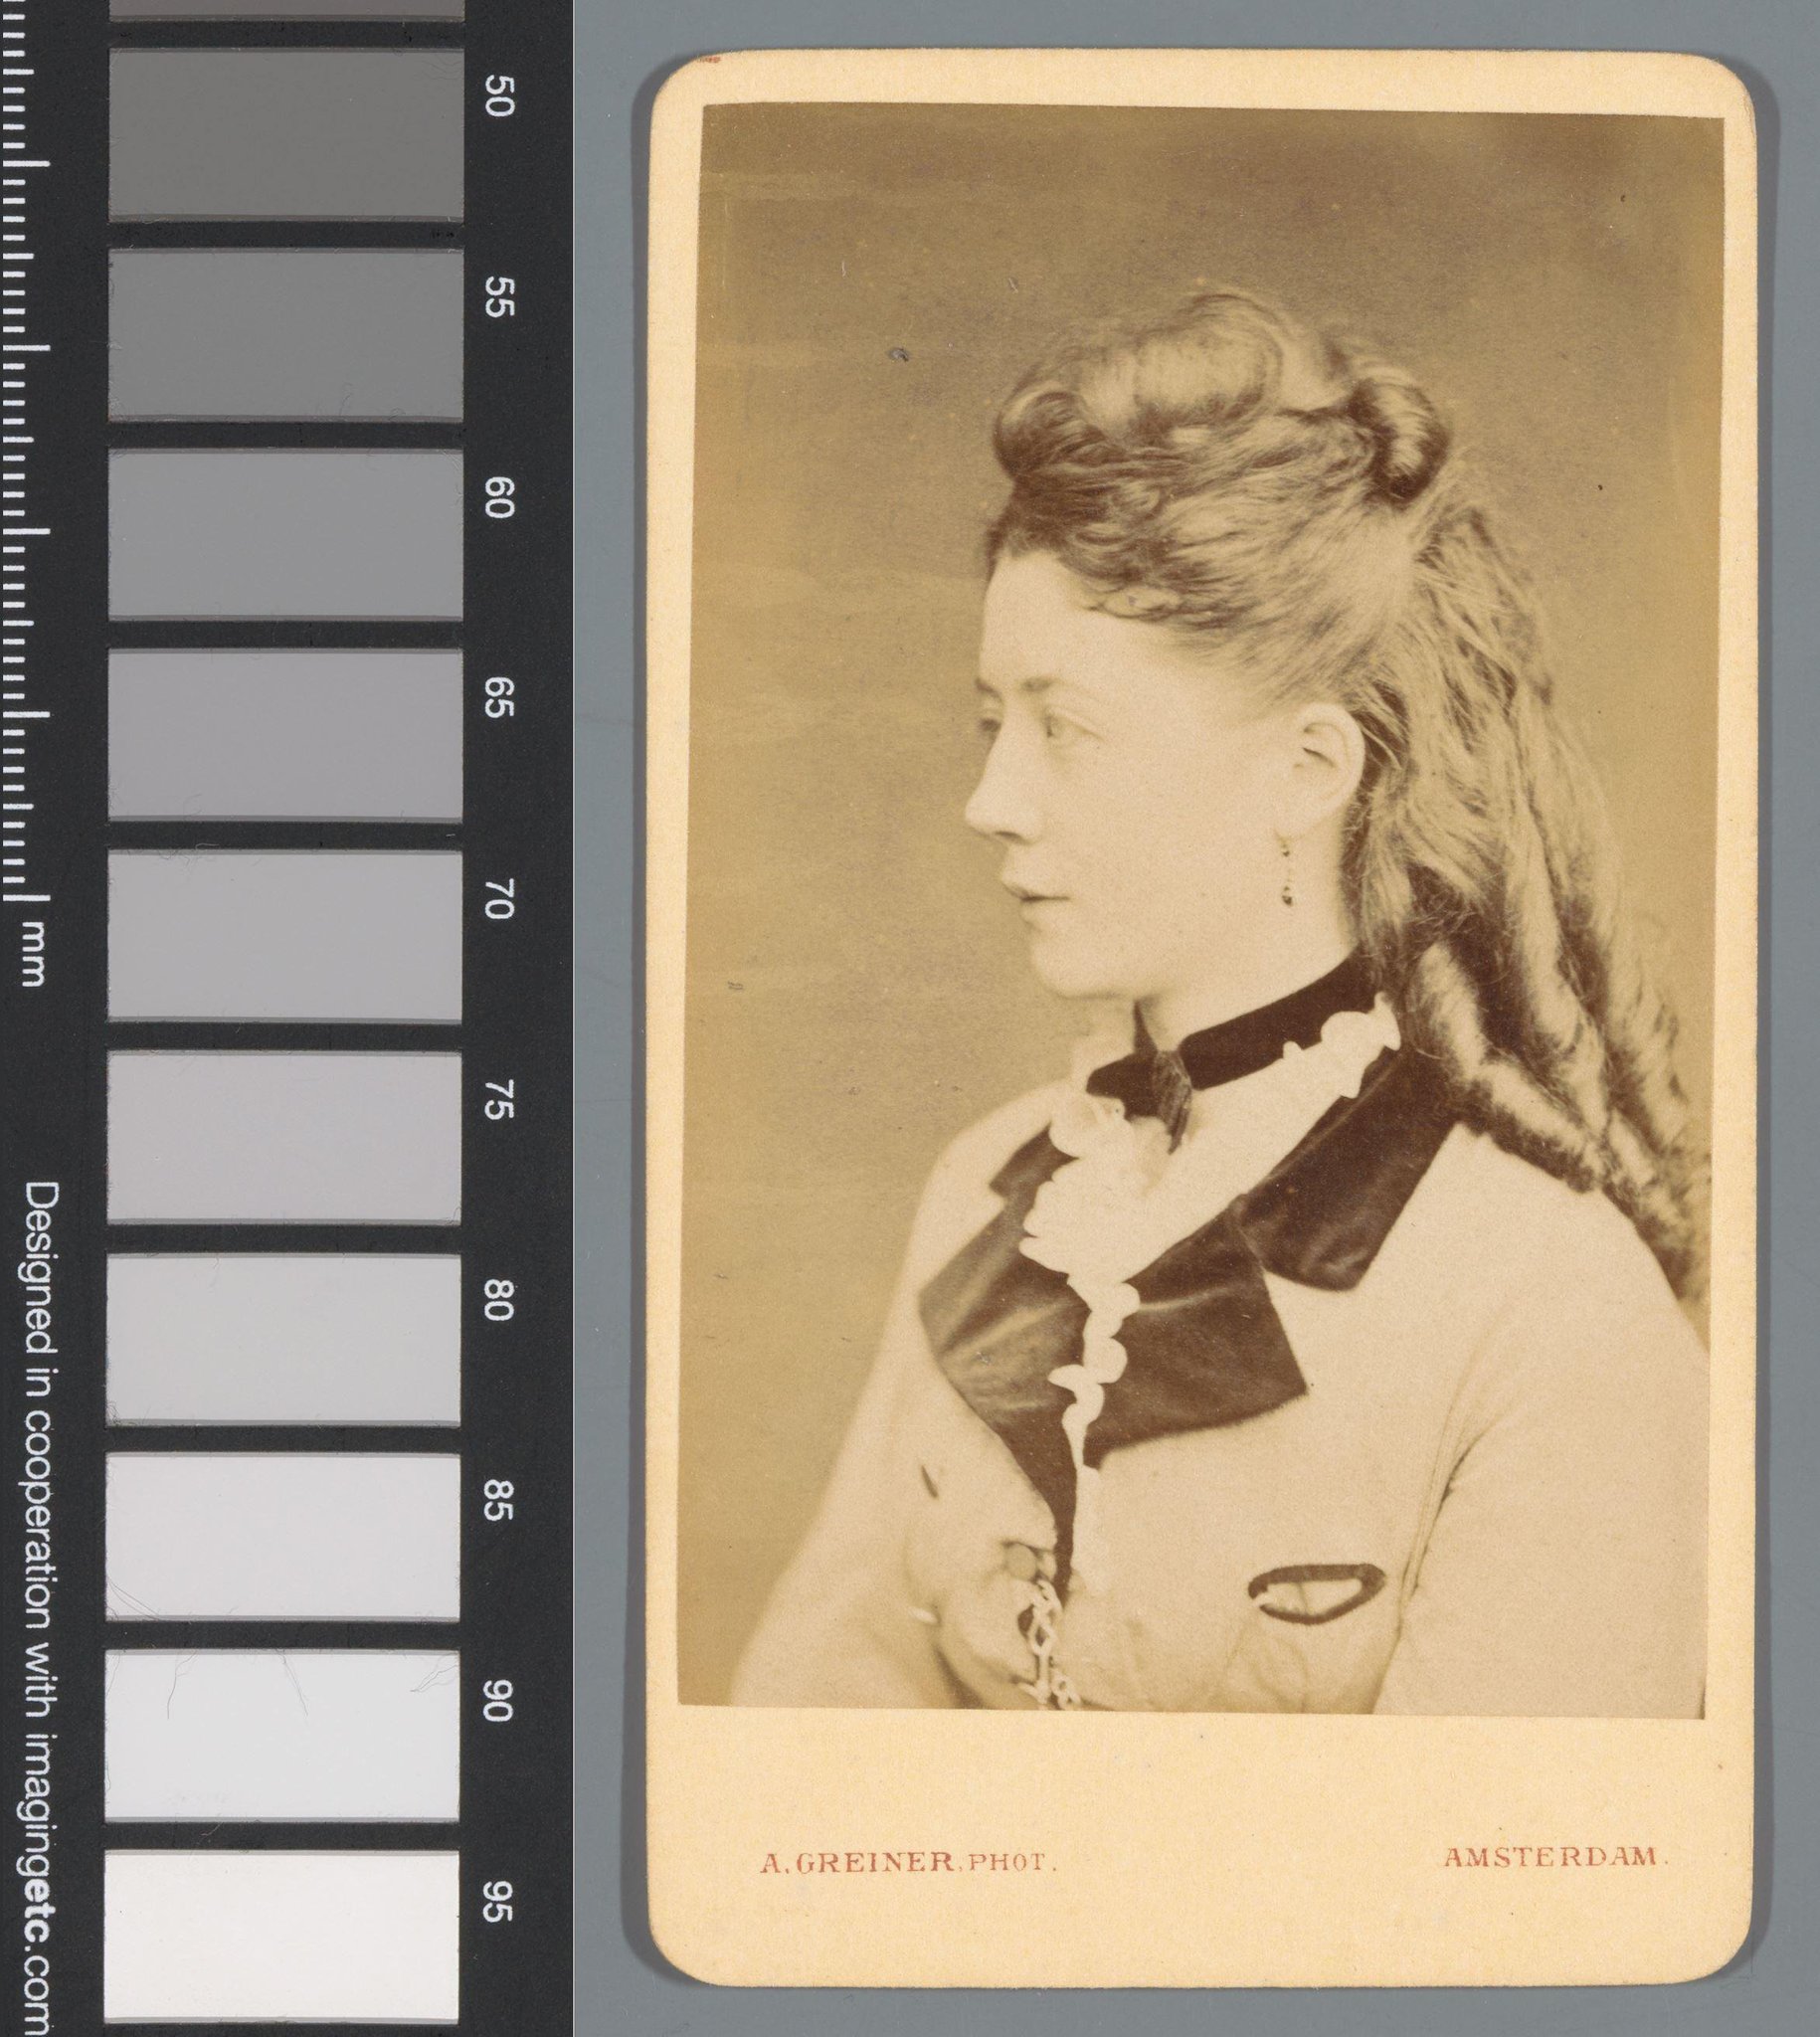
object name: carte de visite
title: Portret van een onbekende vrouw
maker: albert greiner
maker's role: fotograaf, fotostudio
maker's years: 1833-1890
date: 1861-1874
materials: cardboard, paper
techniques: albumen print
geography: amsterdam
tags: historical persons - bb - woman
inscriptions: inscription: ‘AG/ A. GREINER/ Photograf/ NIEUWENDIJK L. 87/ AMSTERDAM.’